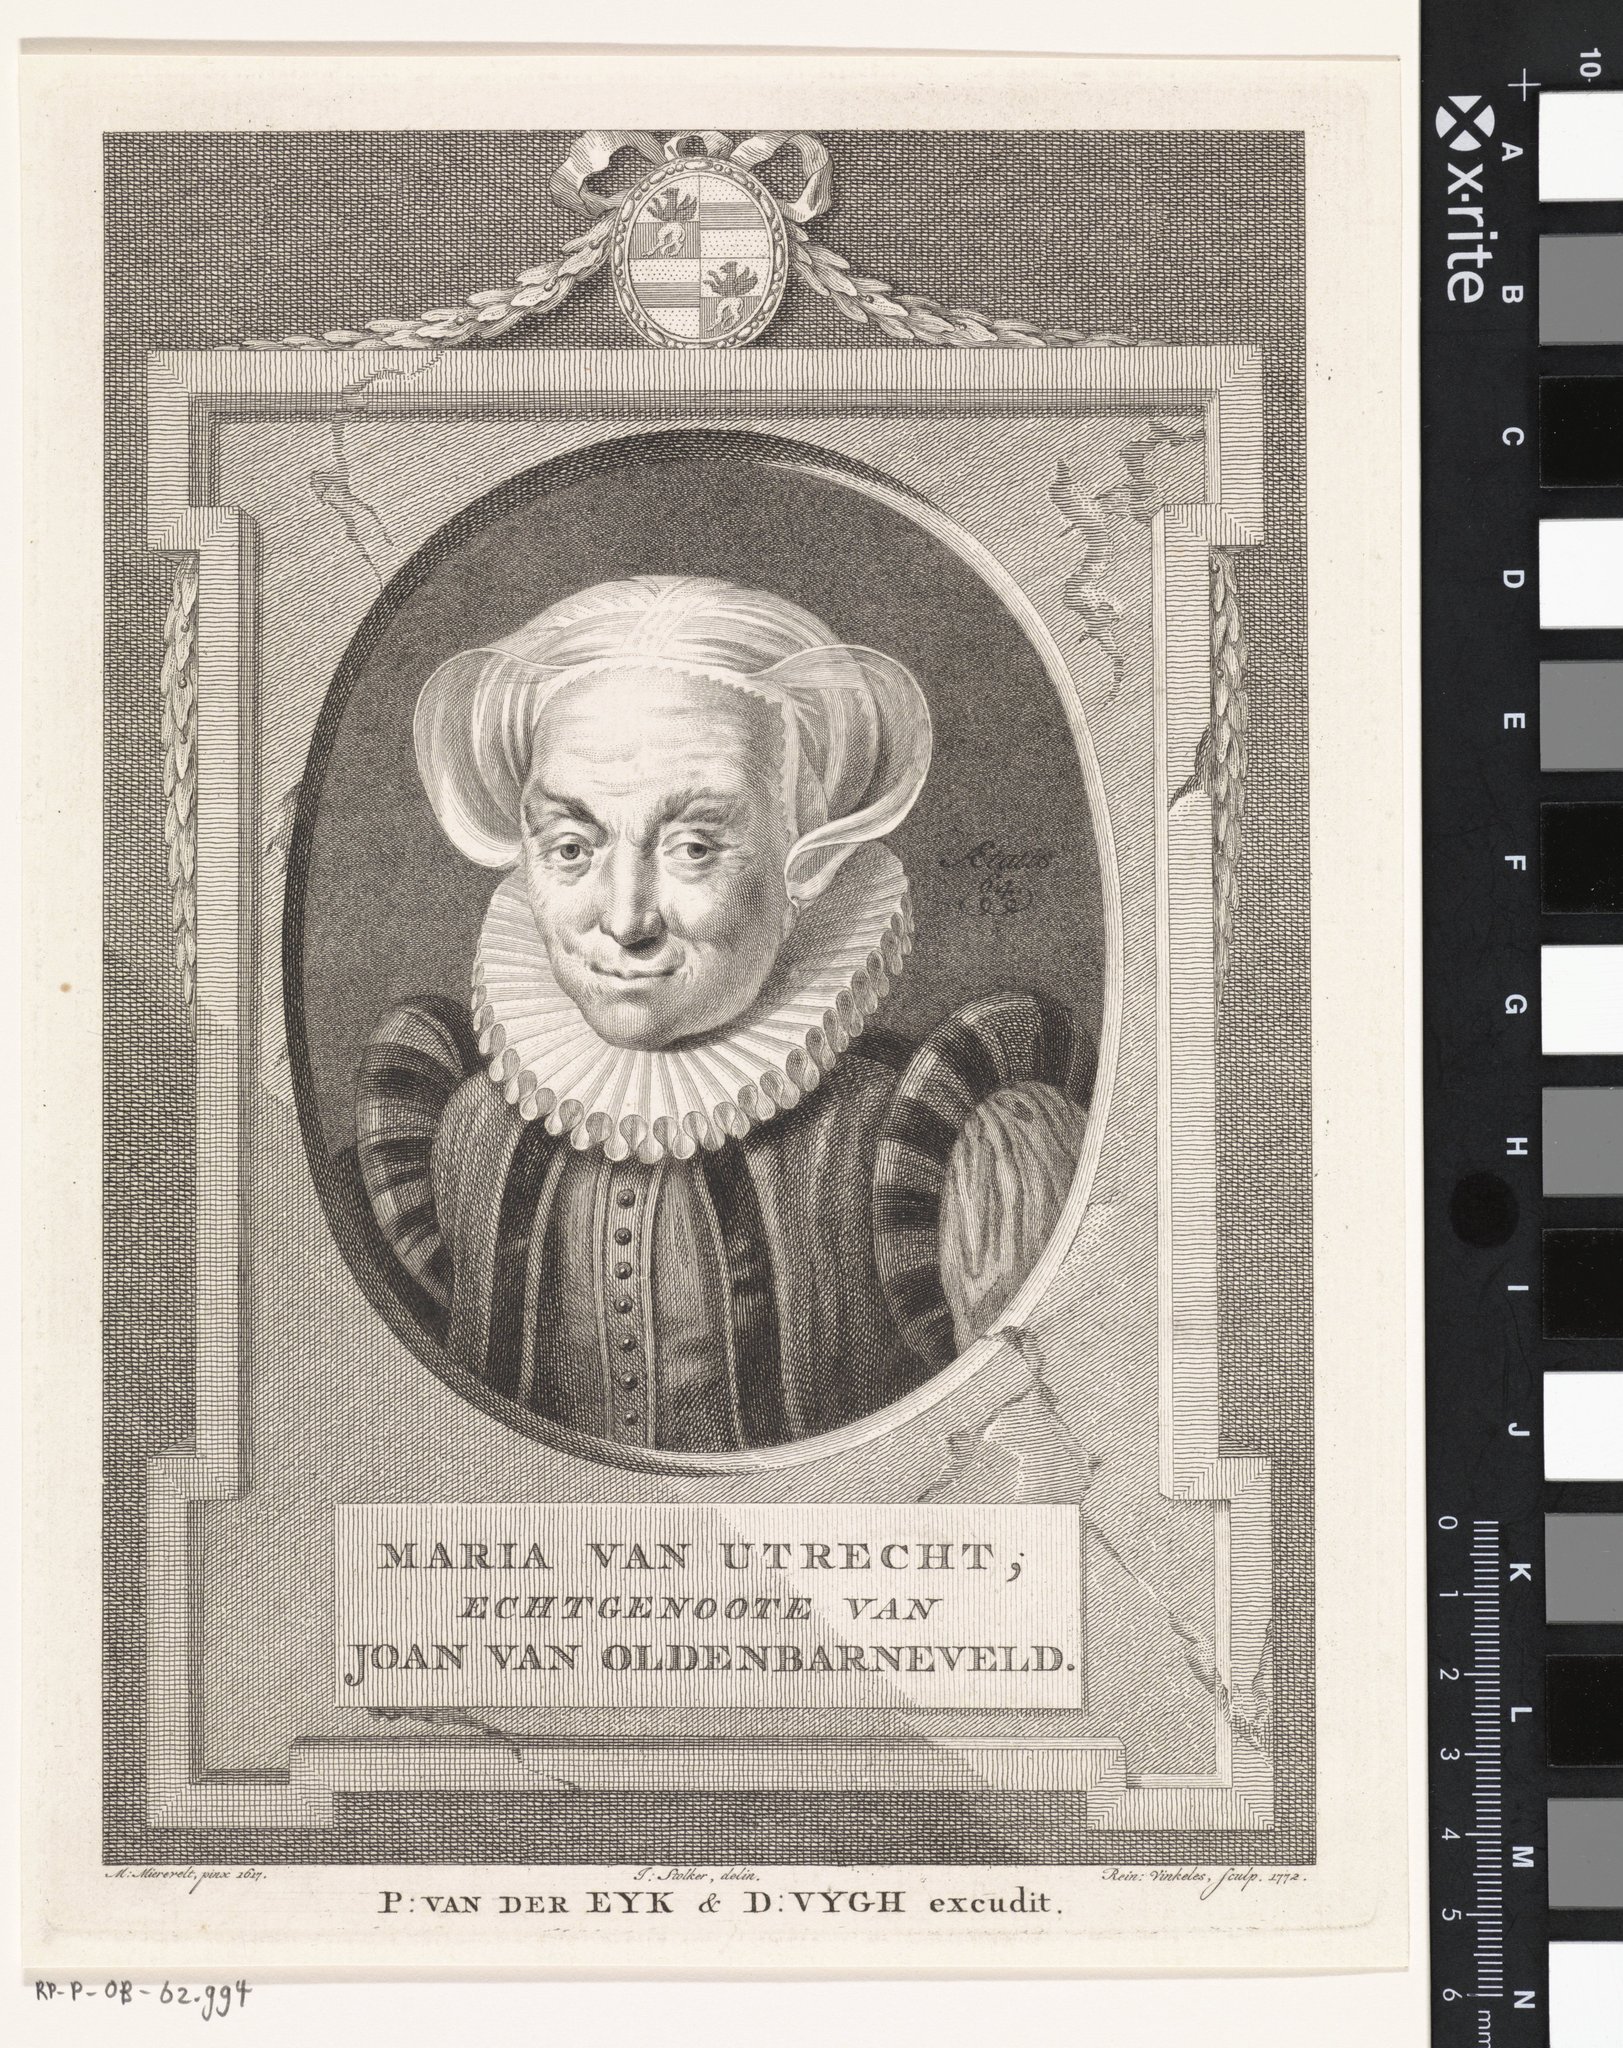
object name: print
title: Portret van Maria van Utrecht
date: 1772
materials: paper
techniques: engraving, etching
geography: leiden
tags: maria van utrecht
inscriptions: collector's mark: Lugt 2228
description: Portret van Maria van Utrecht, echtgenote van Johan van Oldenbarnevelt. Bovenaan haar wapenschil.